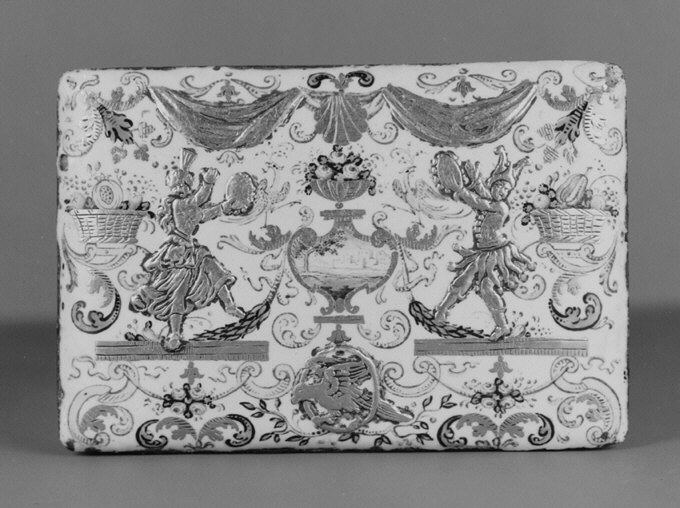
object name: plaque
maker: christian friedrich herold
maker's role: maker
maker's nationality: german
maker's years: 1700-1779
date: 1730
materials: copper, enamel, gold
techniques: painting, relief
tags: human figures